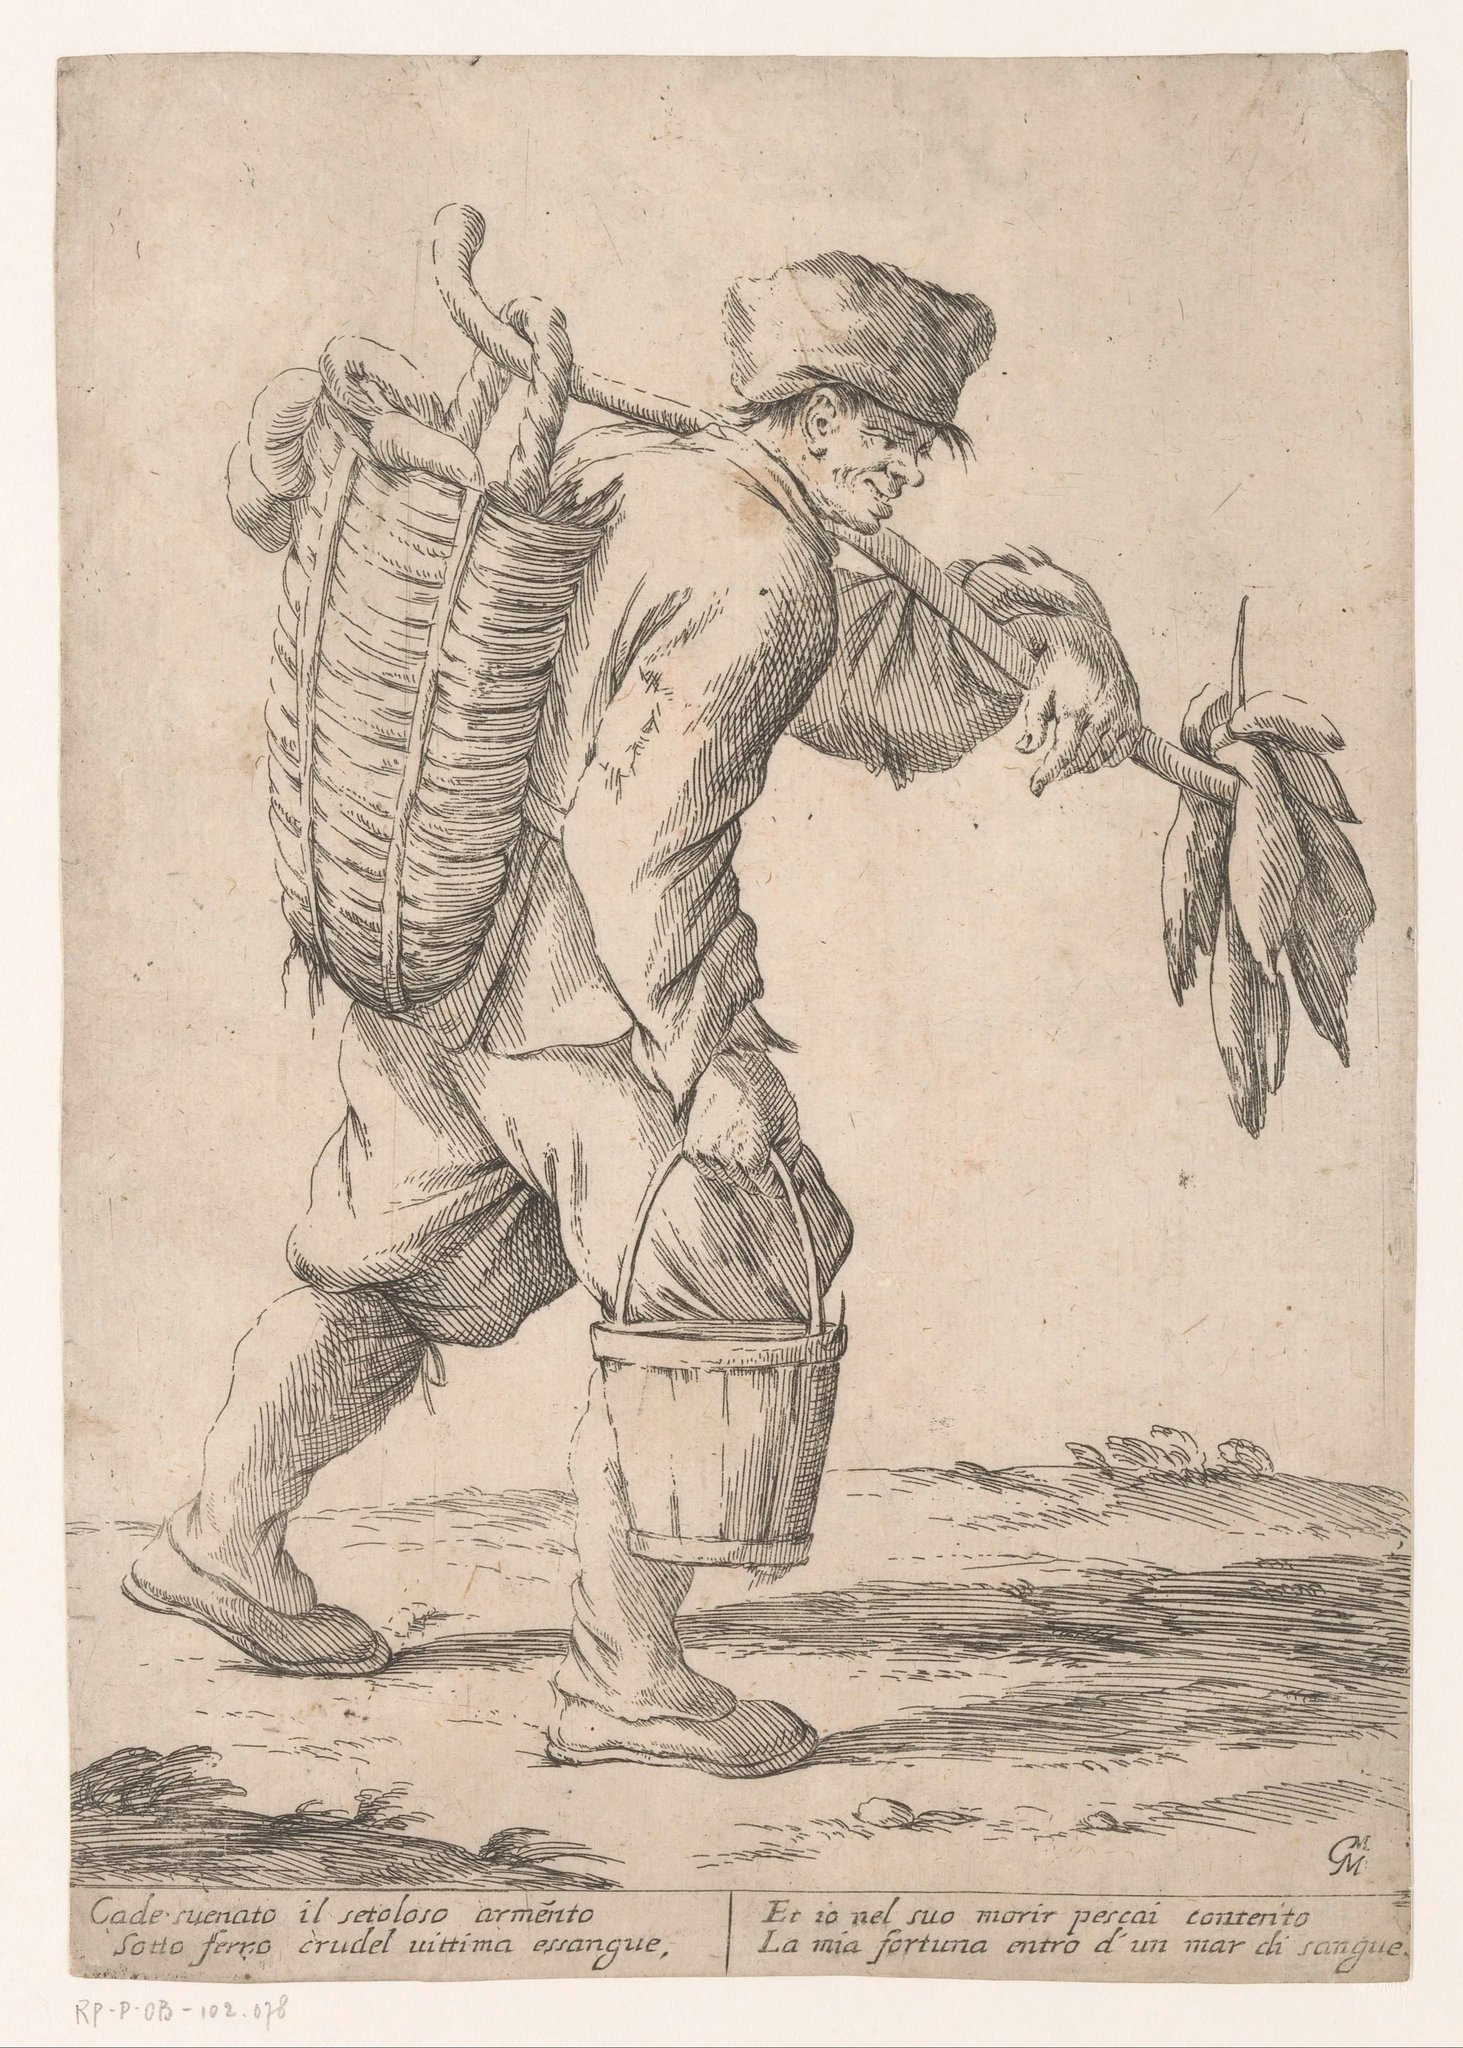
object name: print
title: L'Arti Per Via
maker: giuseppe maria mitelli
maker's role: draughtsman, painter, print maker, publisher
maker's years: 1634-1718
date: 1660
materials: paper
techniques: etching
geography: italy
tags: street-trader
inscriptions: collector's mark: Lugt 2228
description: Een pensverkoper, lopend naar rechts, met in de rechterhand een emmer en over de linkerschouder een stok. Italiaans vers in ondermarge.